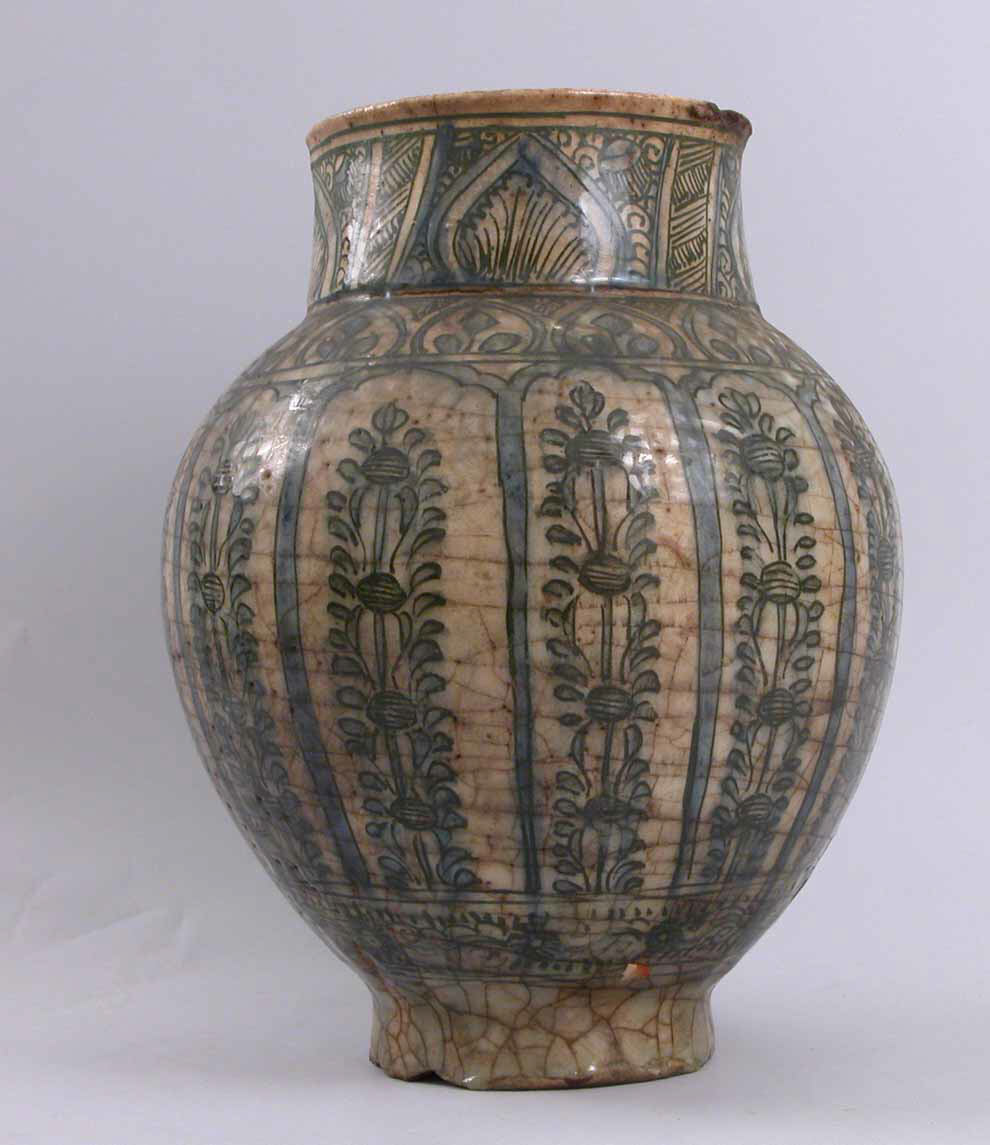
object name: jar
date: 1601-1700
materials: stonepaste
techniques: painting, underglaze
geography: iran